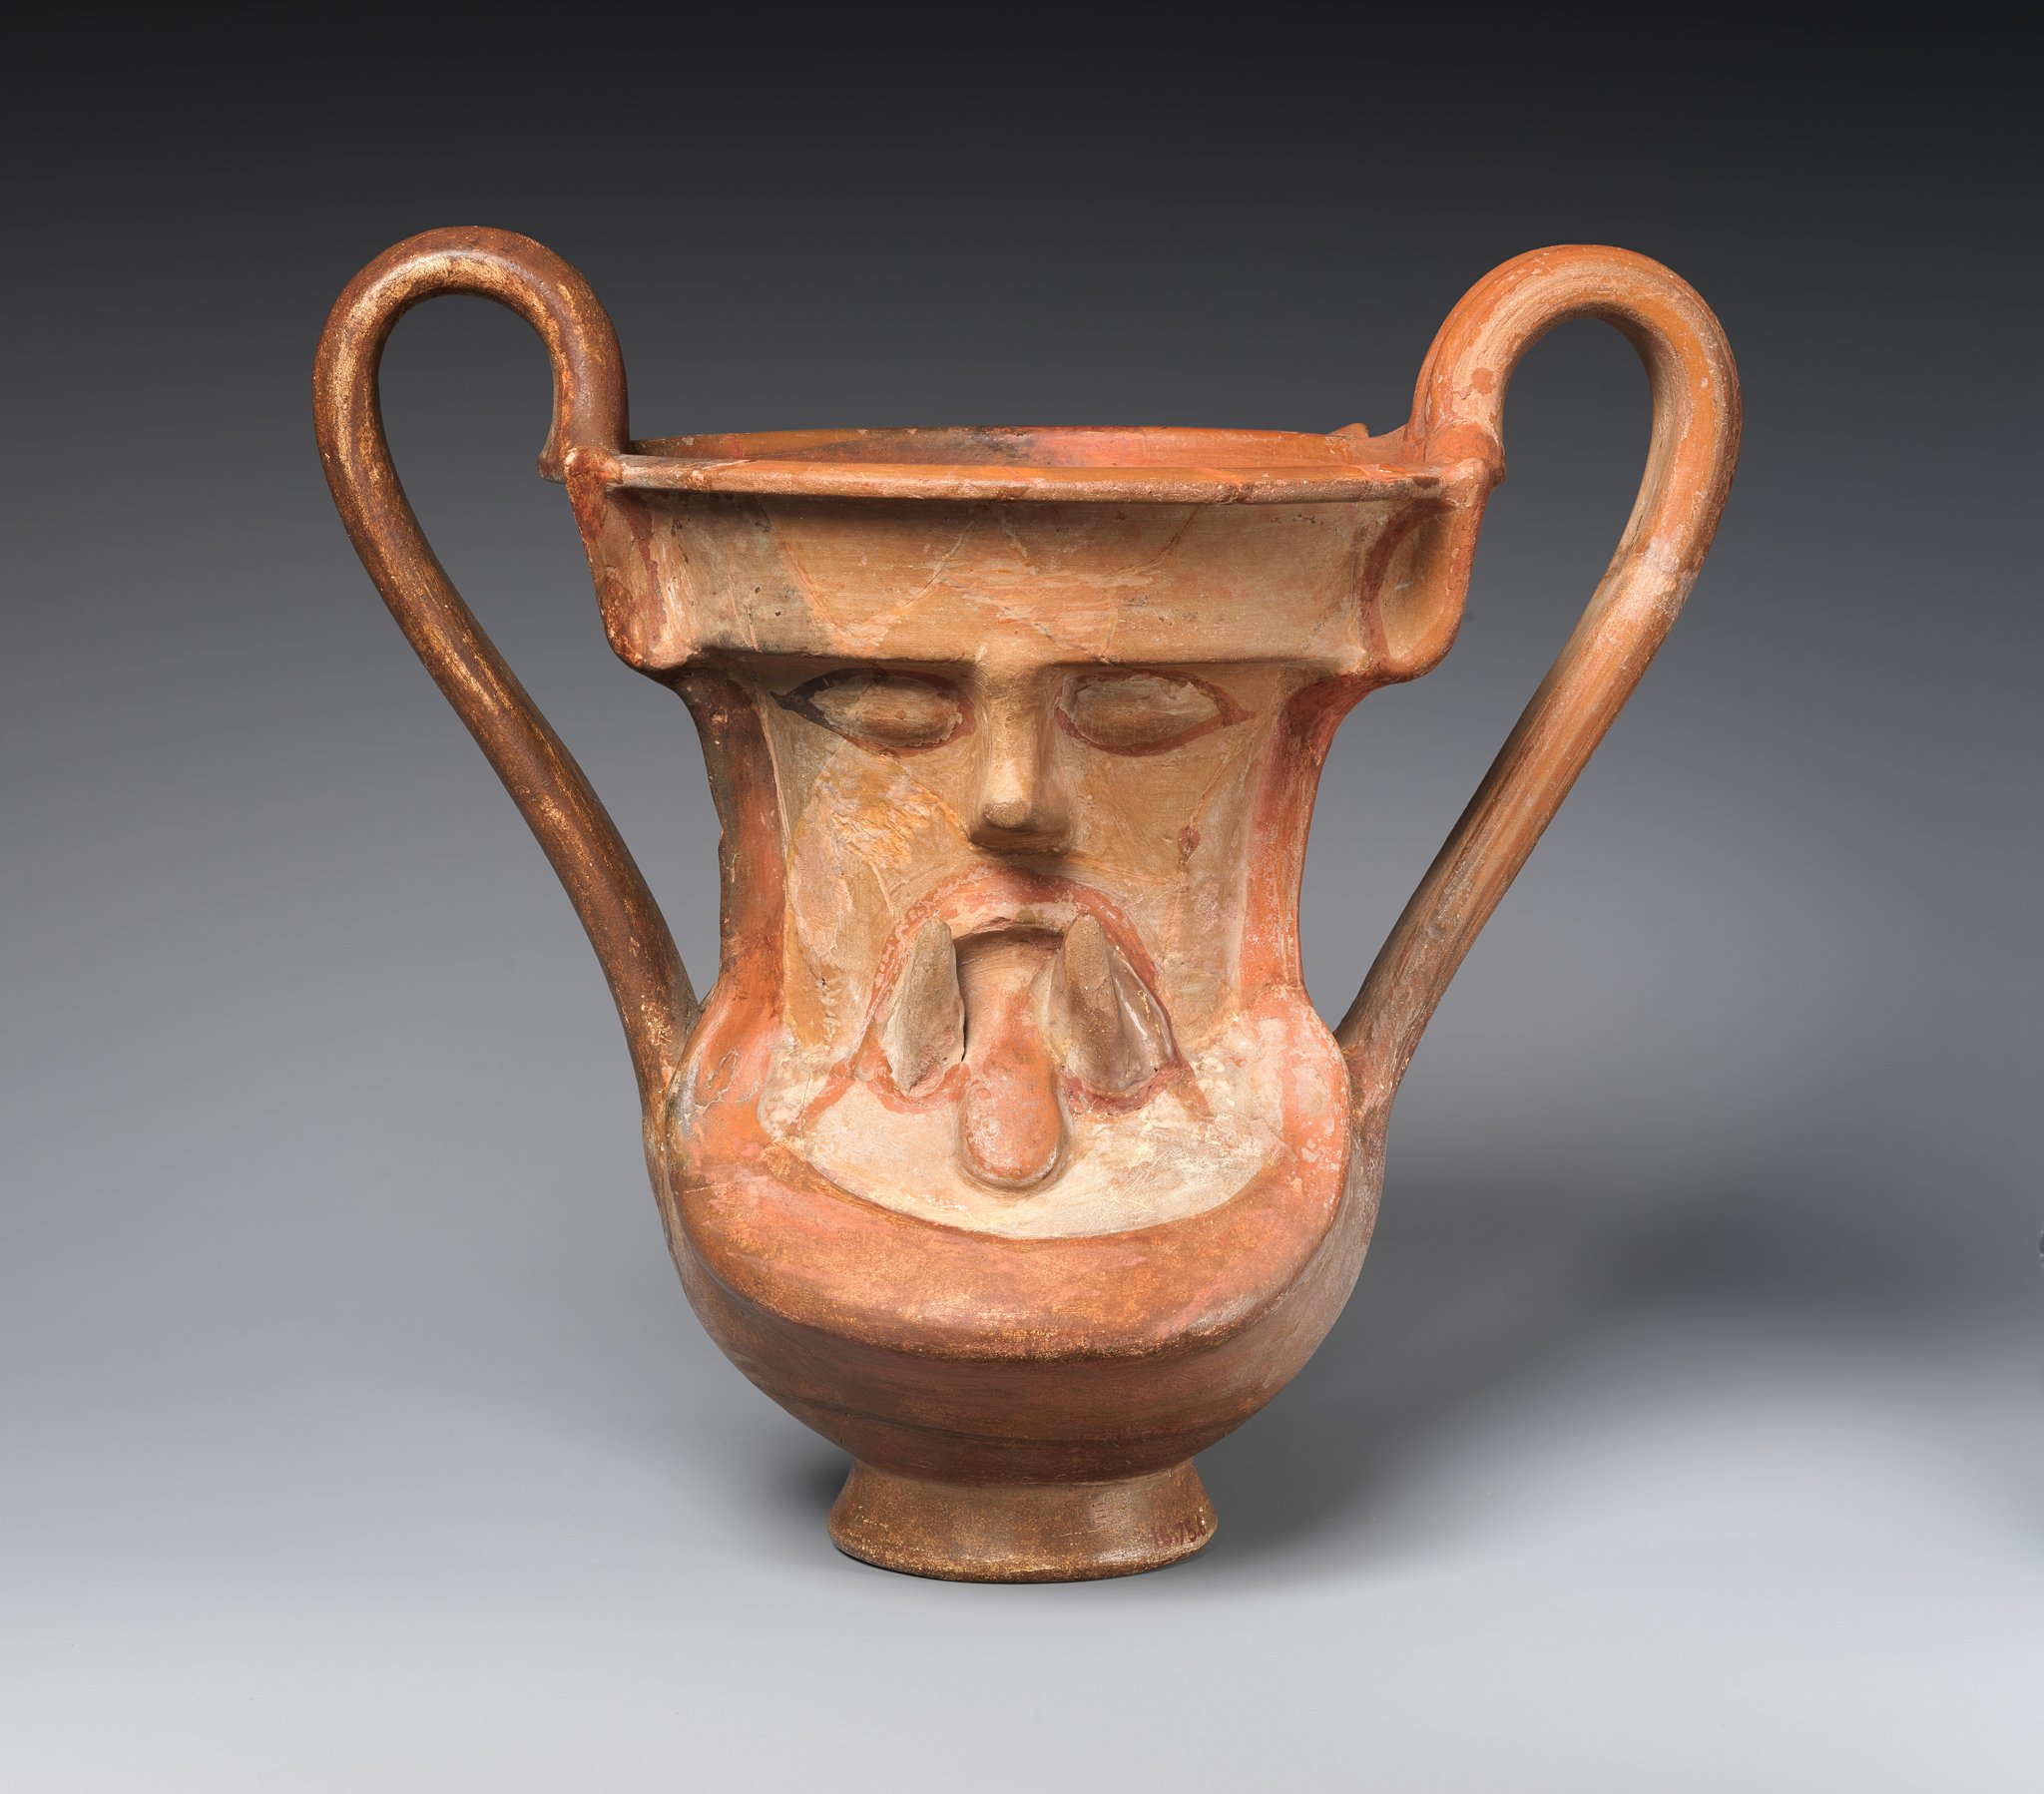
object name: kantharos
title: Terracotta kantharos (wine cup) with a satyr's mask on both sides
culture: lydian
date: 600-501 BCE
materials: terracotta